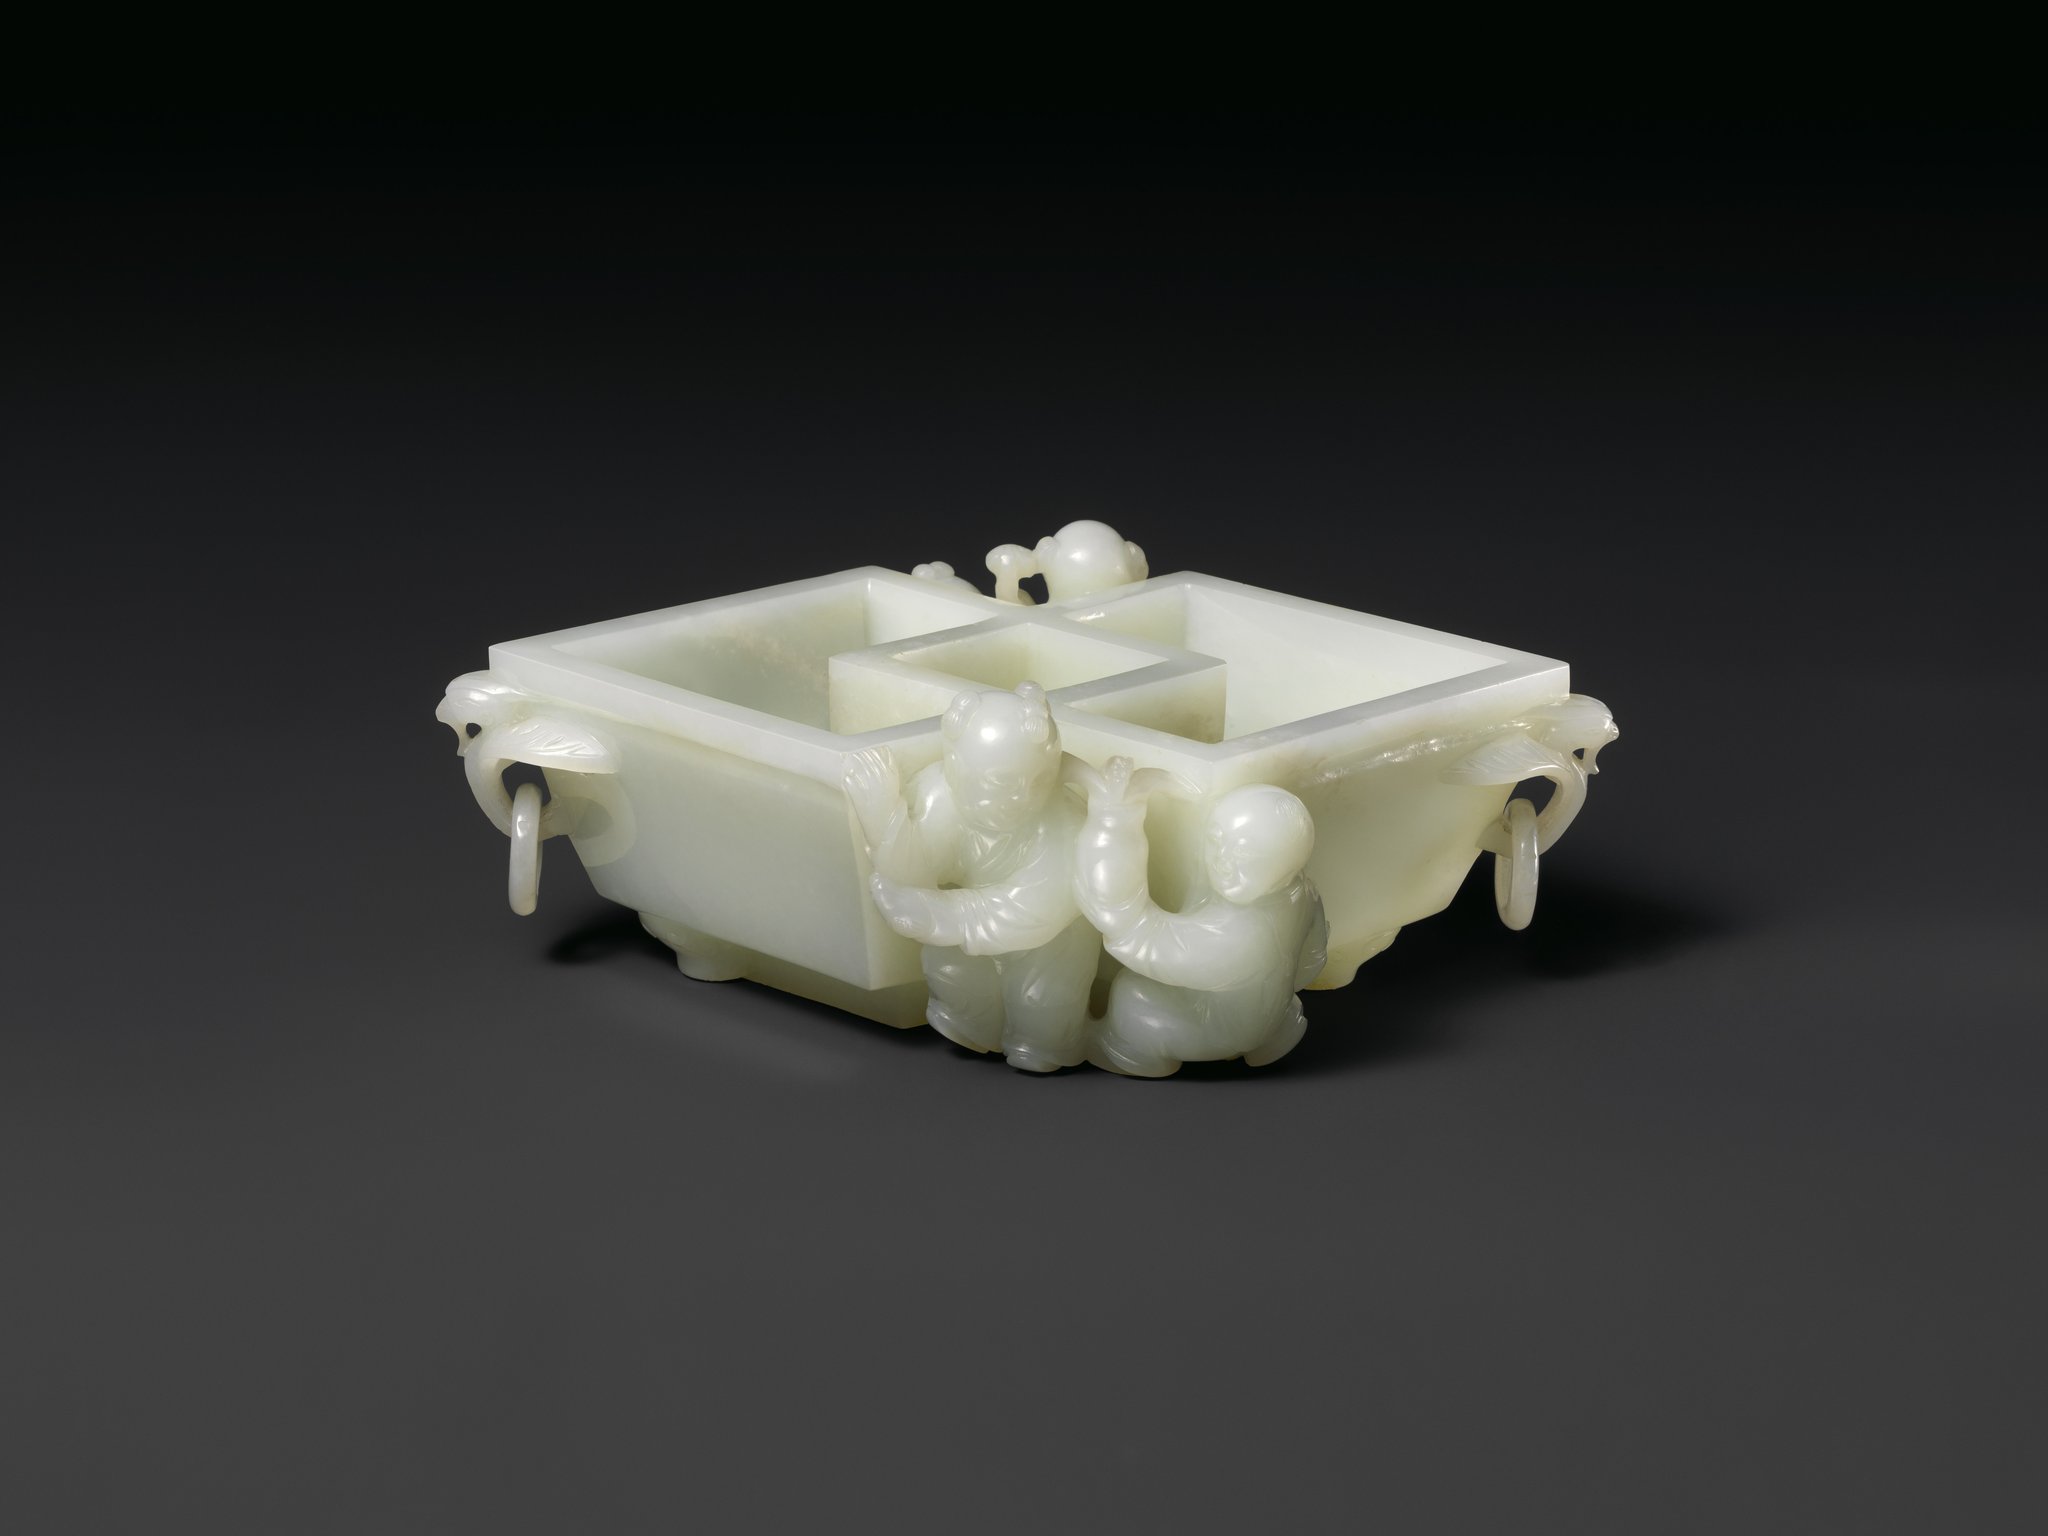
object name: water vessel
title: Water vessel in the shape of a marriage cup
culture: chinese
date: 1701-1800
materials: jade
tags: human figures